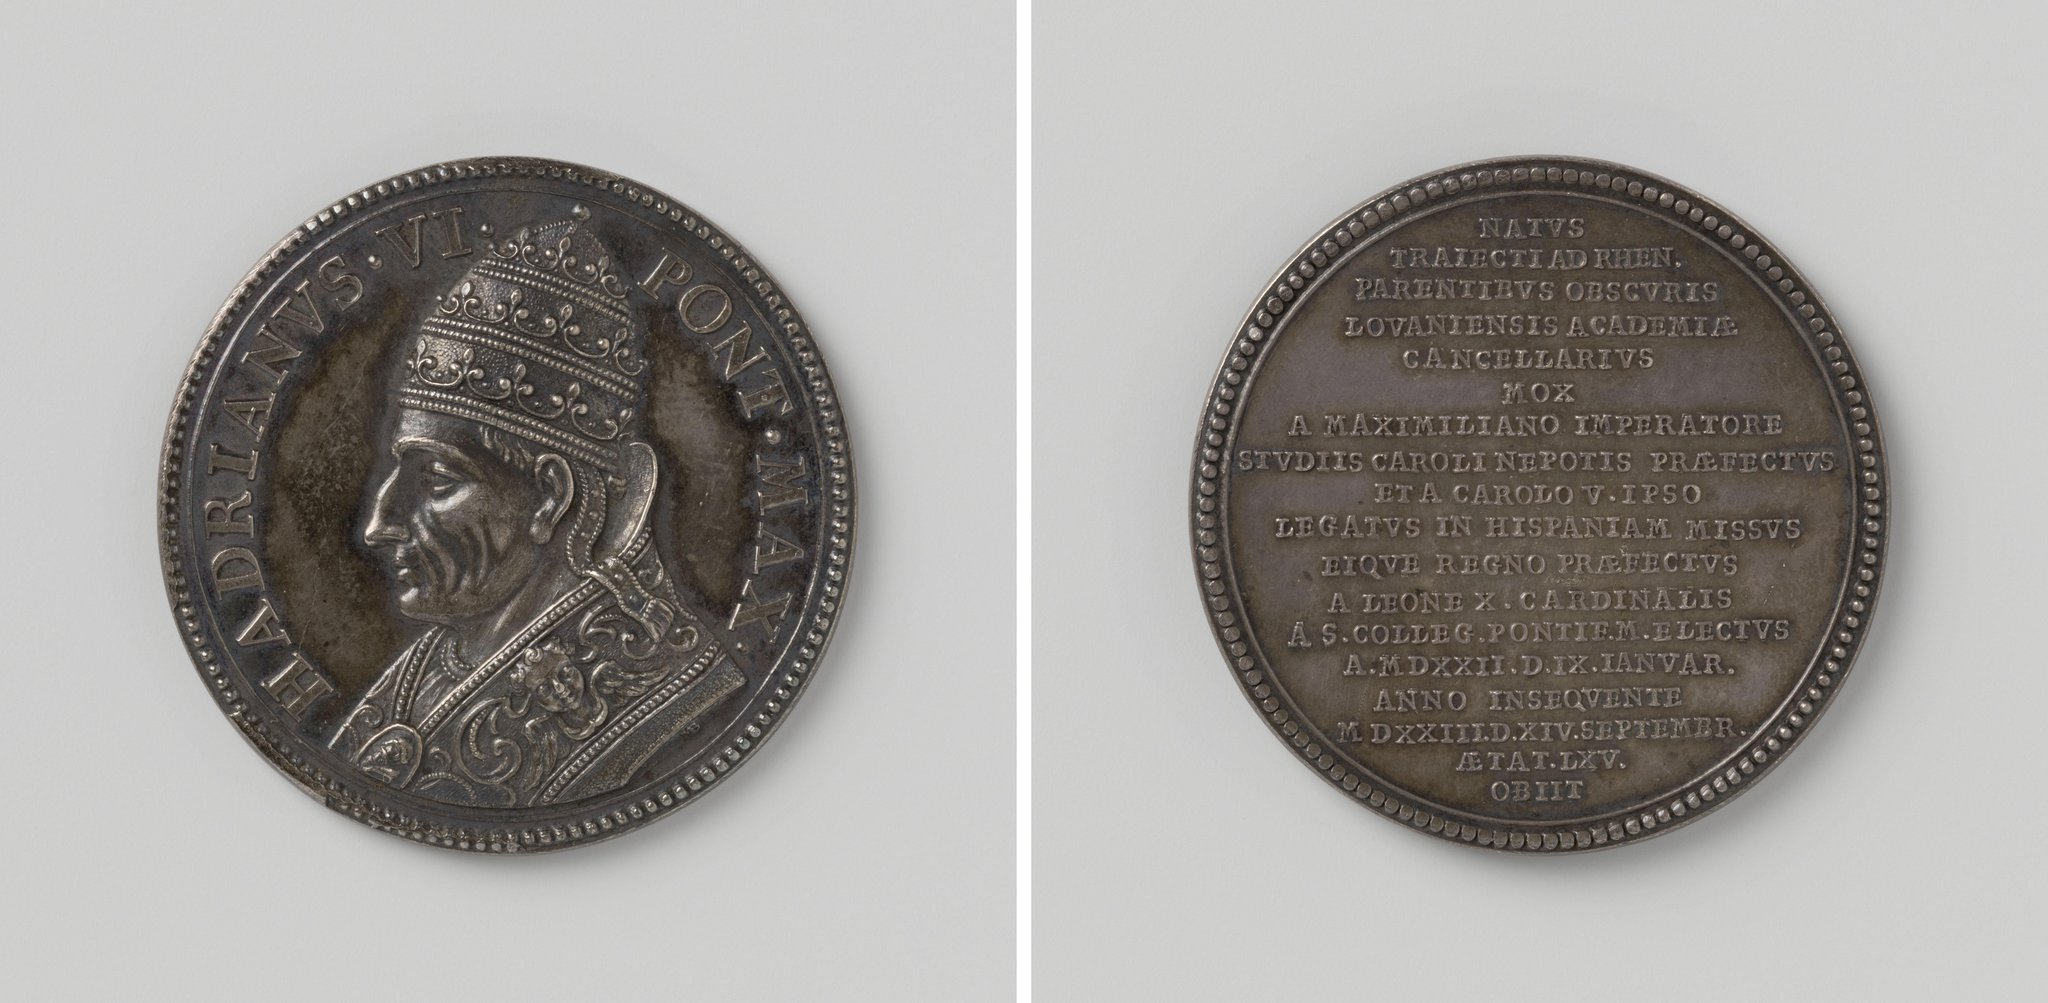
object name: history medal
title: Paus Adrianus VI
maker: monogrammist mb (medailleur)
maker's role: medailleur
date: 1650-1750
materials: silver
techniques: striking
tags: utrecht, rome, clergyman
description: Zilveren penning. Voorzijde: borststuk man met tiara binnen omschrift. Keerzijde: opschrift